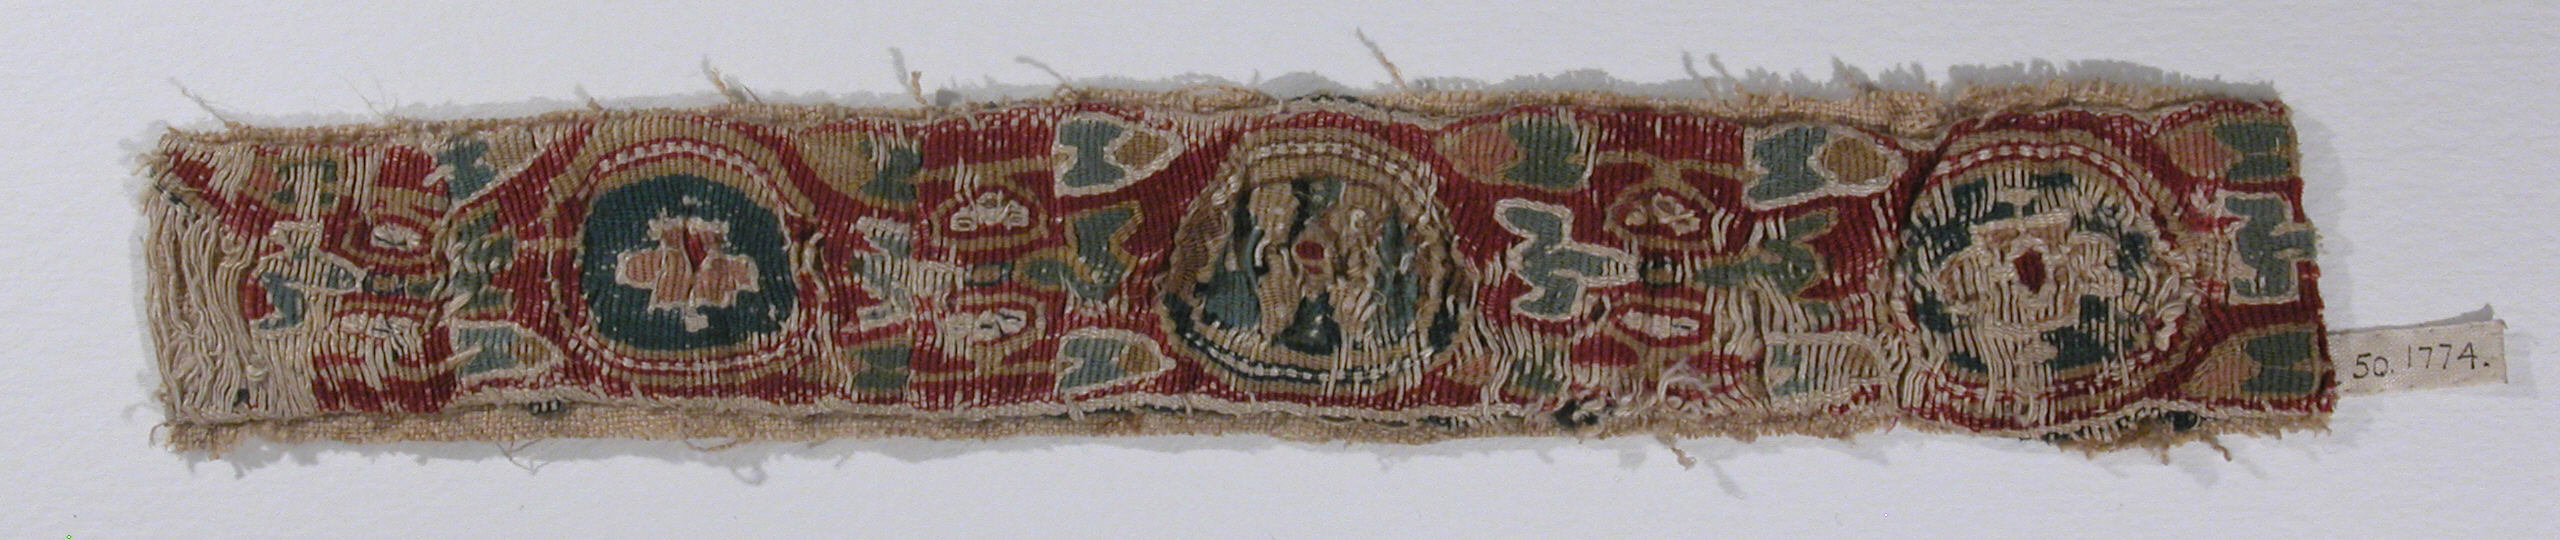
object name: band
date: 501-800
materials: linen, wool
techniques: weave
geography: egypt